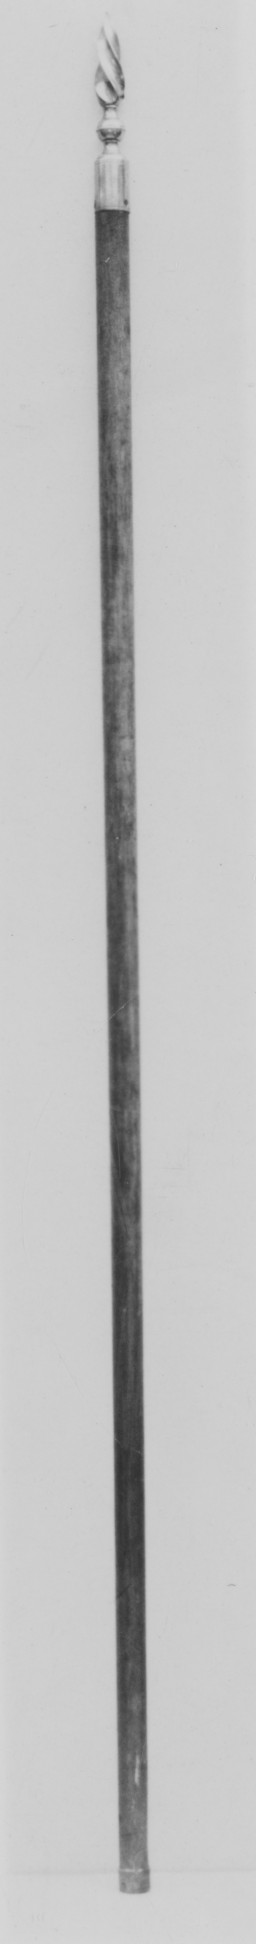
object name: court staff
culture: american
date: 1765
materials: wood, brass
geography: united states